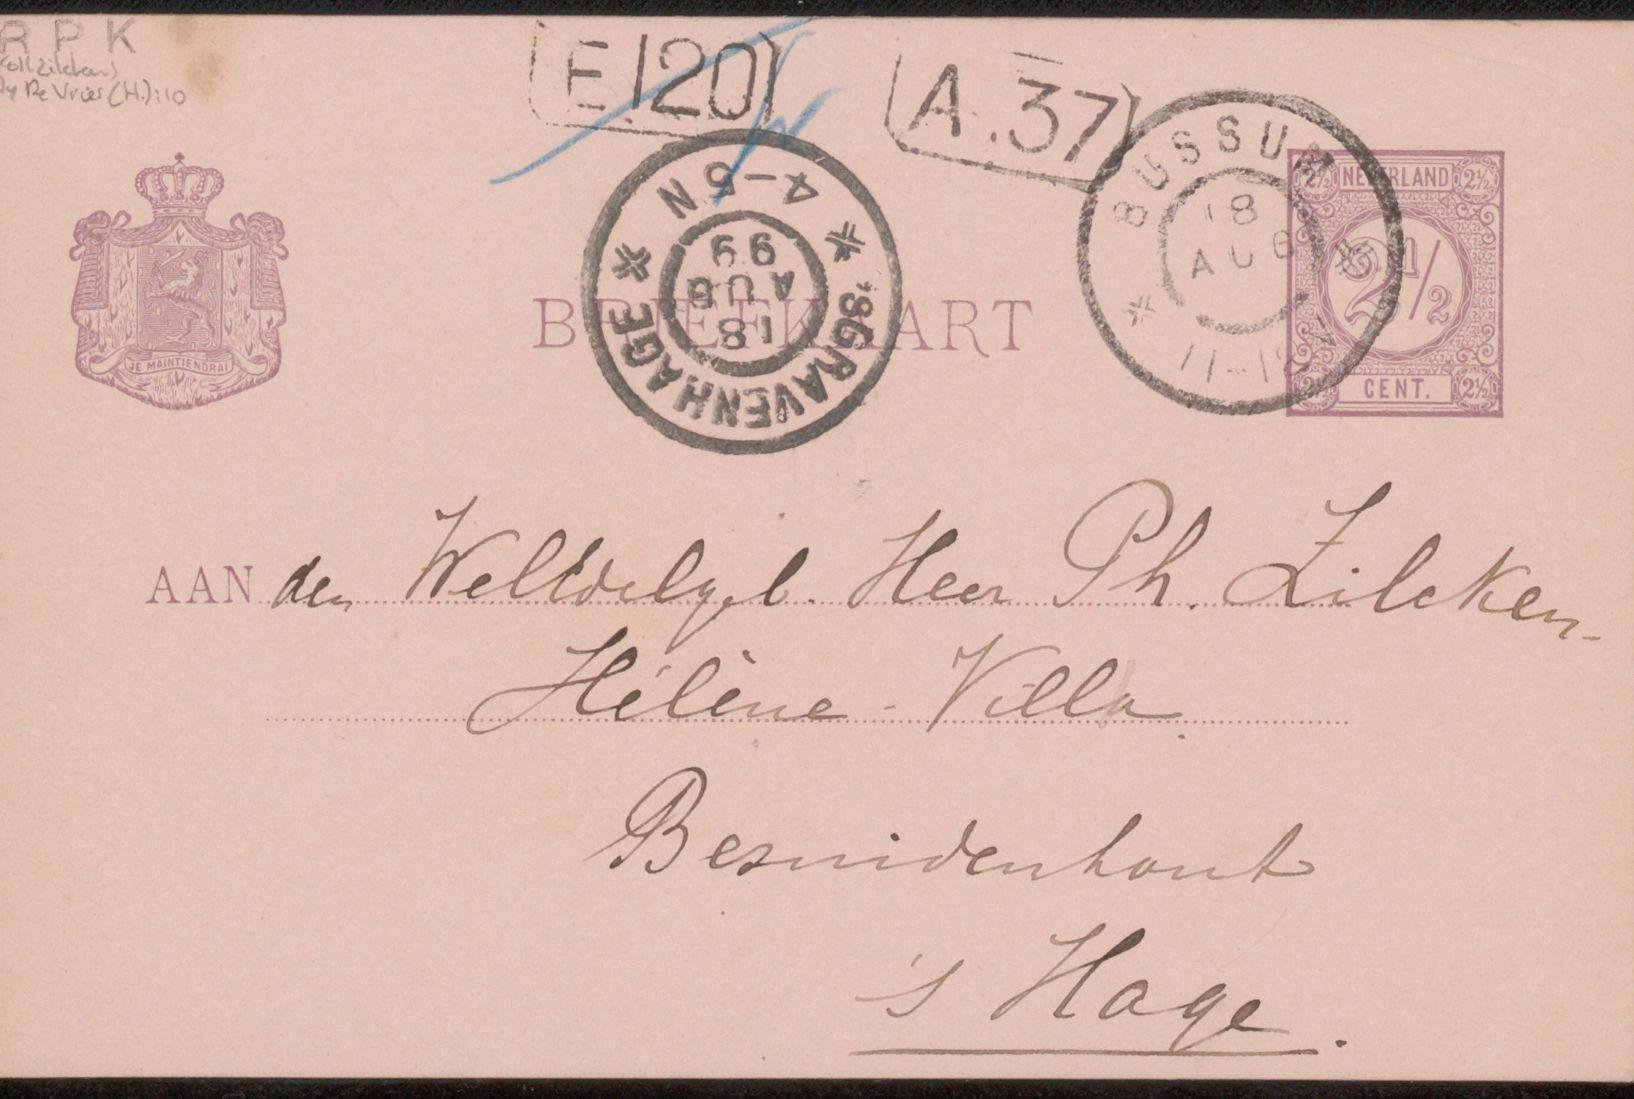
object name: postcard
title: Briefkaart aan Philip Zilcken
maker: henriëtte de vries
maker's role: draughtsman, print maker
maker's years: 1867-1942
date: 1899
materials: cardboard, ink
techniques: pen, writing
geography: bussum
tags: berlin, pol de mont, painter, philip zilcken, illustration ~ printed matter, book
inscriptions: collector's mark: ‘RPK’